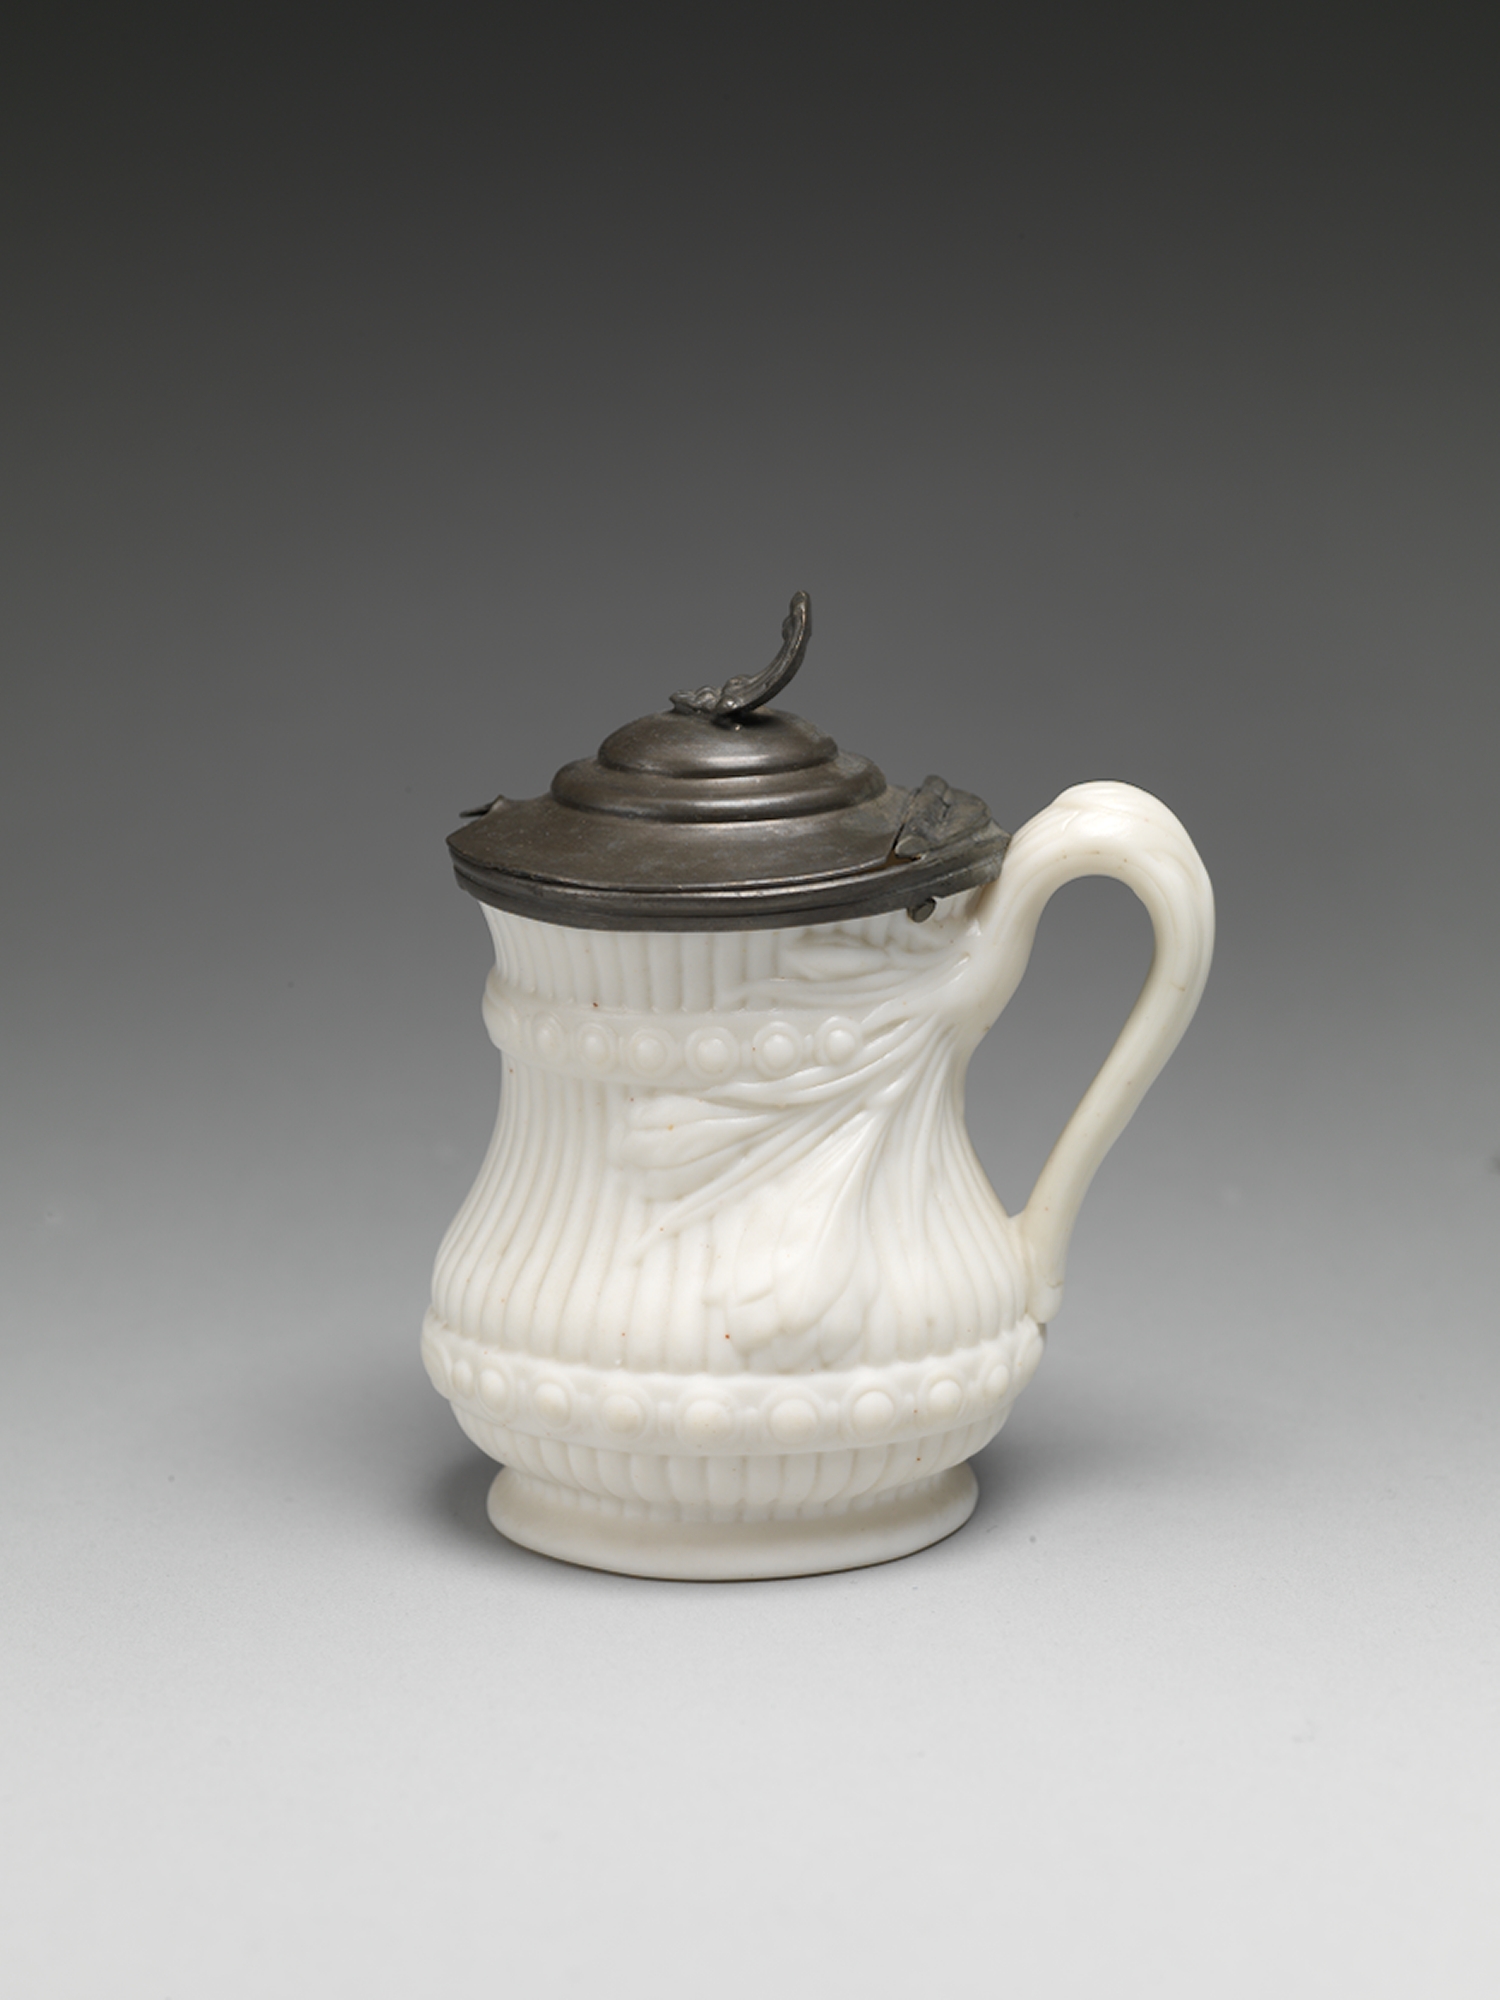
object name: mustard pot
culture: american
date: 1830-1870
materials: porcelain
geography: united states